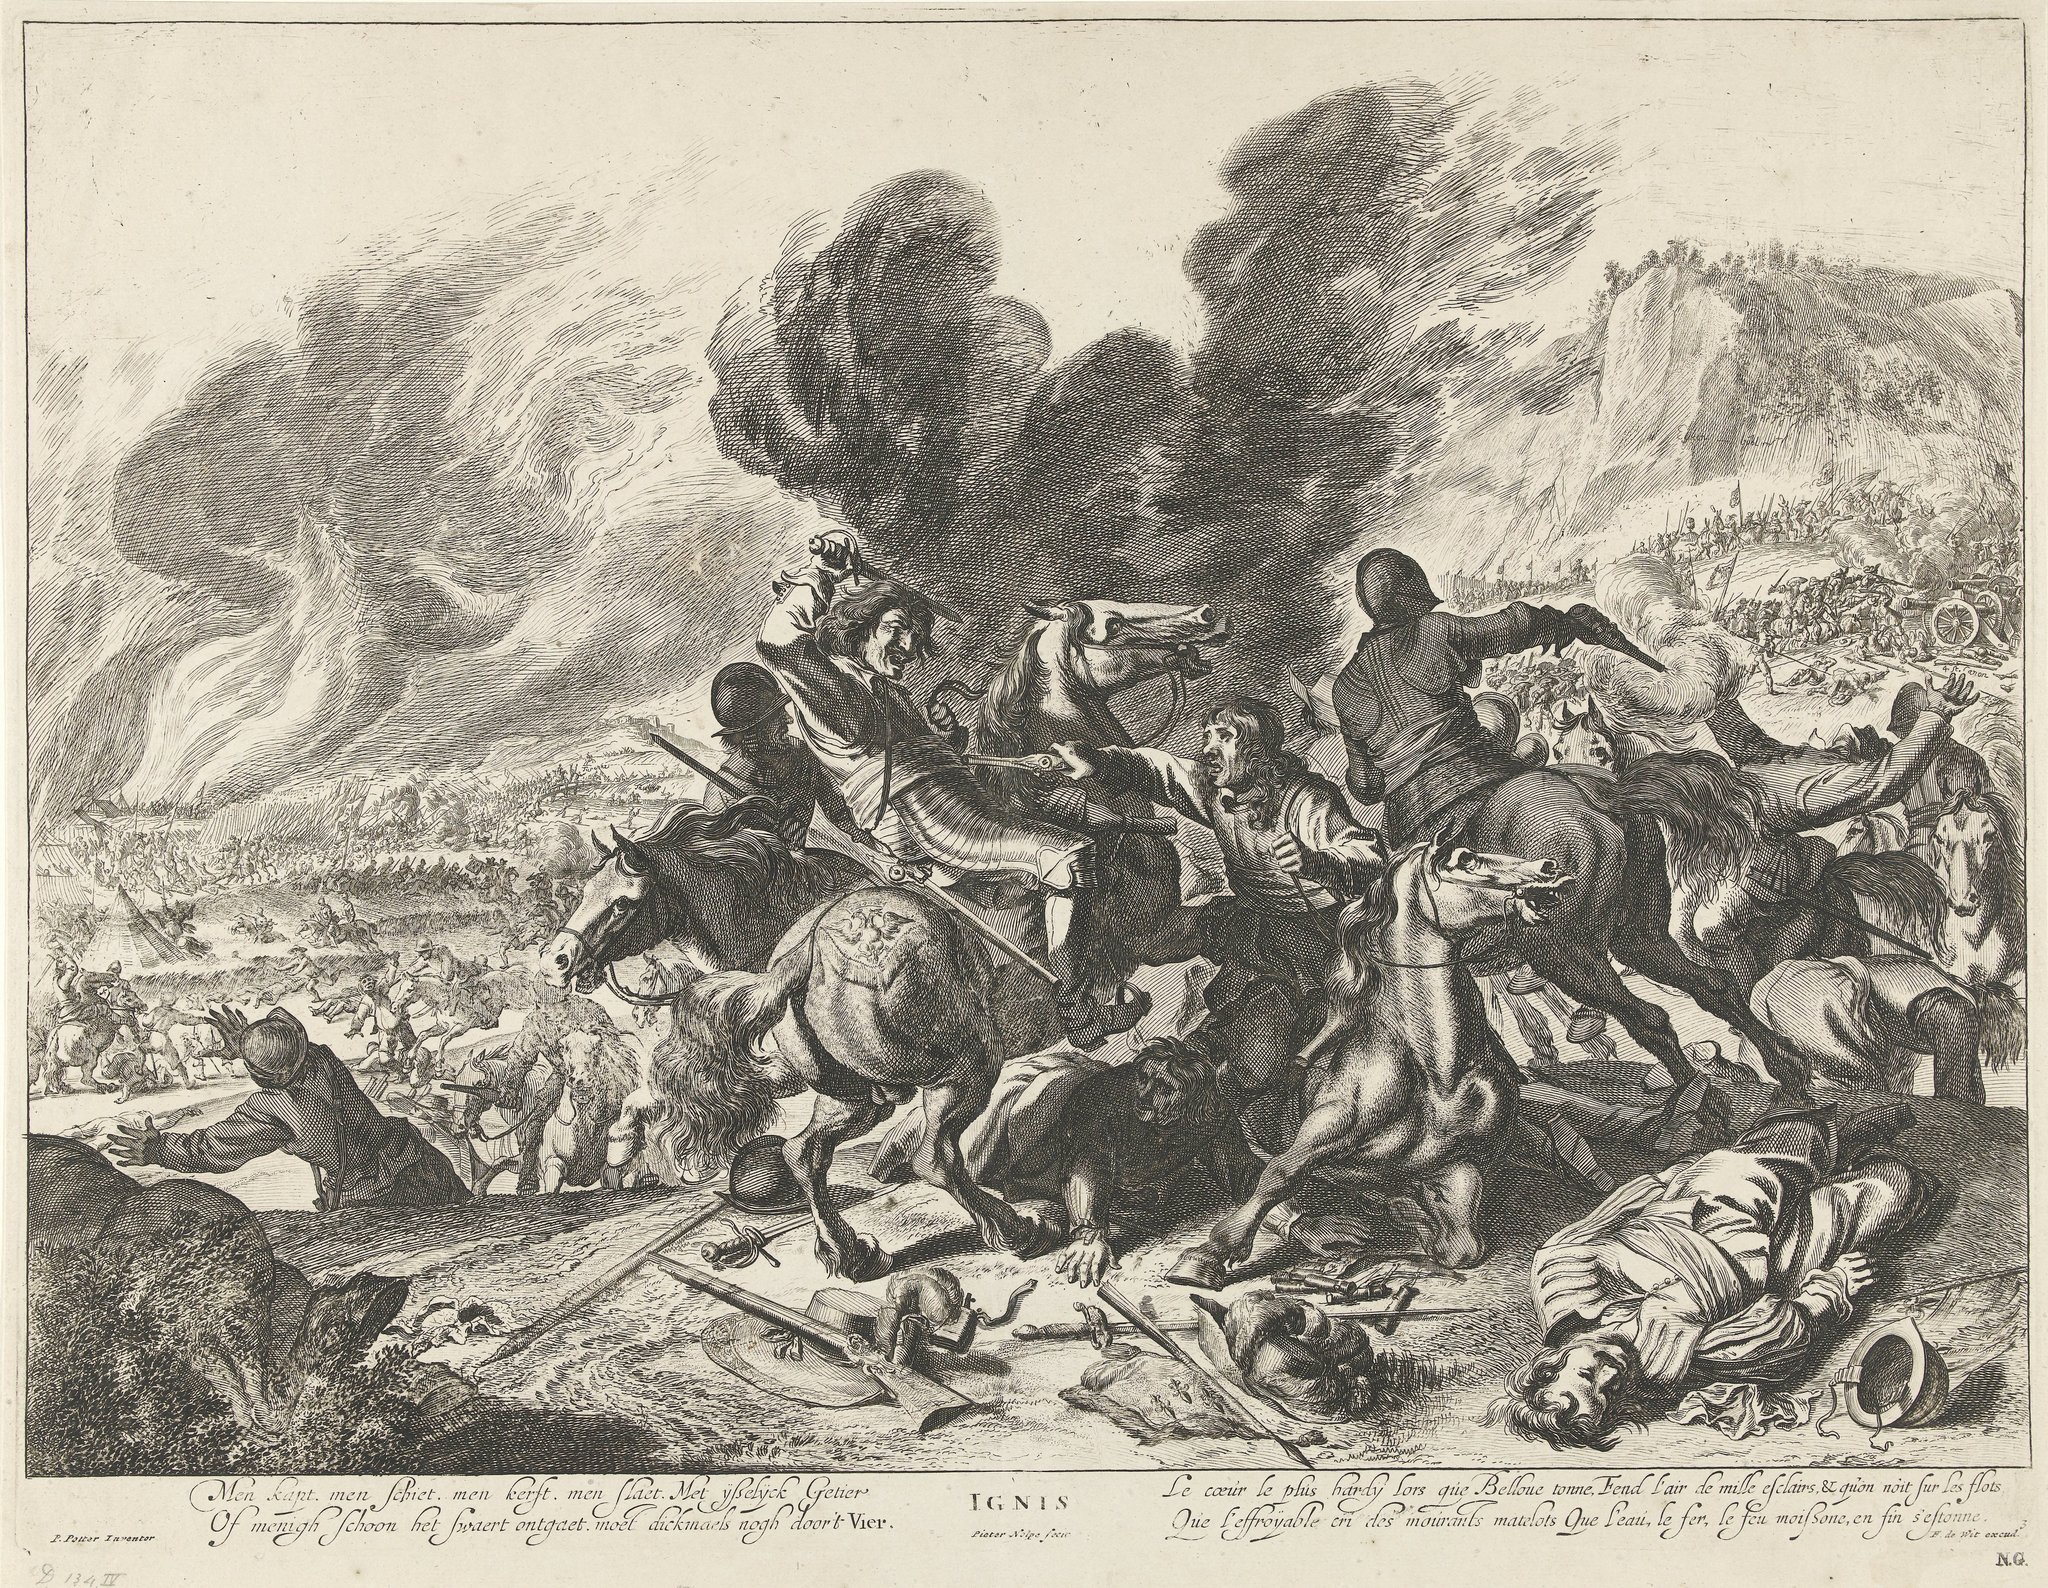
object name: print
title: Veldslag: het element vuur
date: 1640-1706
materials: paper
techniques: engraving, etching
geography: amsterdam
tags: battle (+ land forces)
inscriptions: collector's mark: Lugt 2228, collector's mark: Lugt 1967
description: In een landschap vindt een veldslag plaats tussen ruiters en voetvolk. Onderaan in de marge een tweeregelig vers in het Nederlands en een tweeregelig vers in het Frans. Rechtsonder genummerd: 3. Prent uit een serie van verschillende maanden, die eveneens een element of seizoen verbeelden.